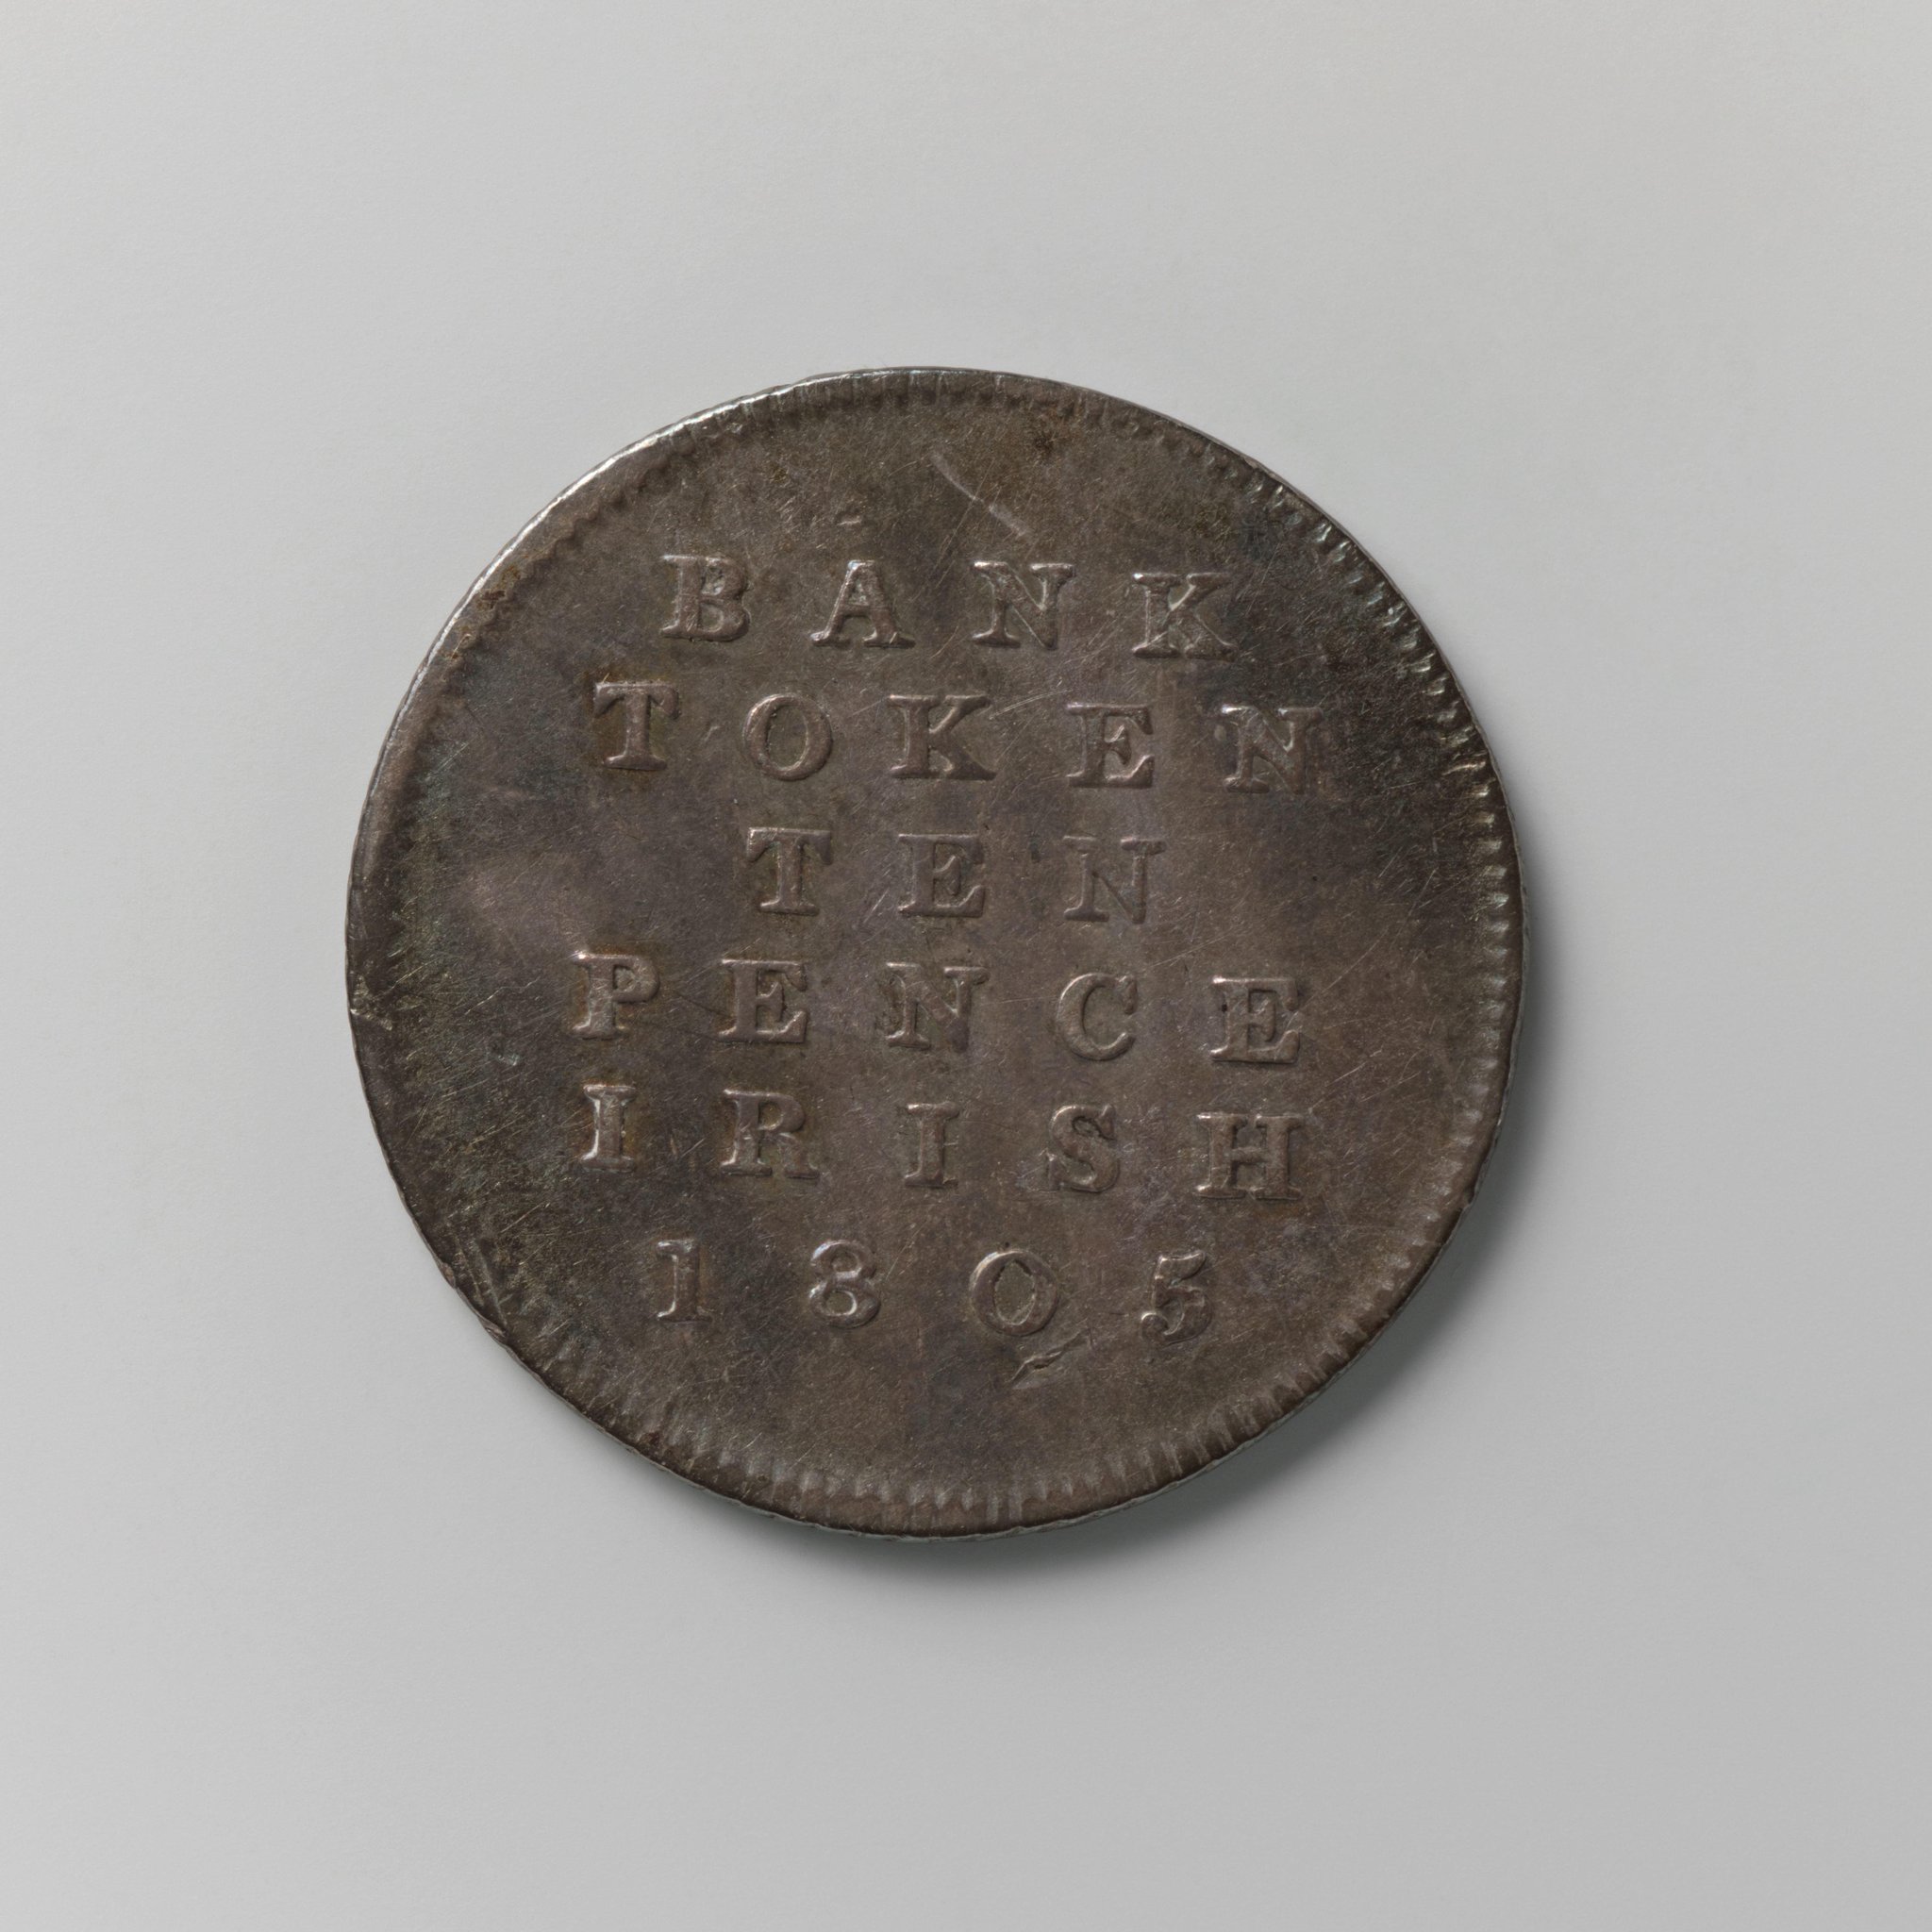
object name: coin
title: Ierland, George III, 10 pence, 1805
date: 1805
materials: silver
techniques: striking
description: Zilveren munt. Voorzijde: gelauwerd borstbeeld van de vorst naar rechts. Keerzijde: vijf-regelige waarde-aanduiding: Bank token ten pence Irish. Daaronder jaartal. Kabelrand.